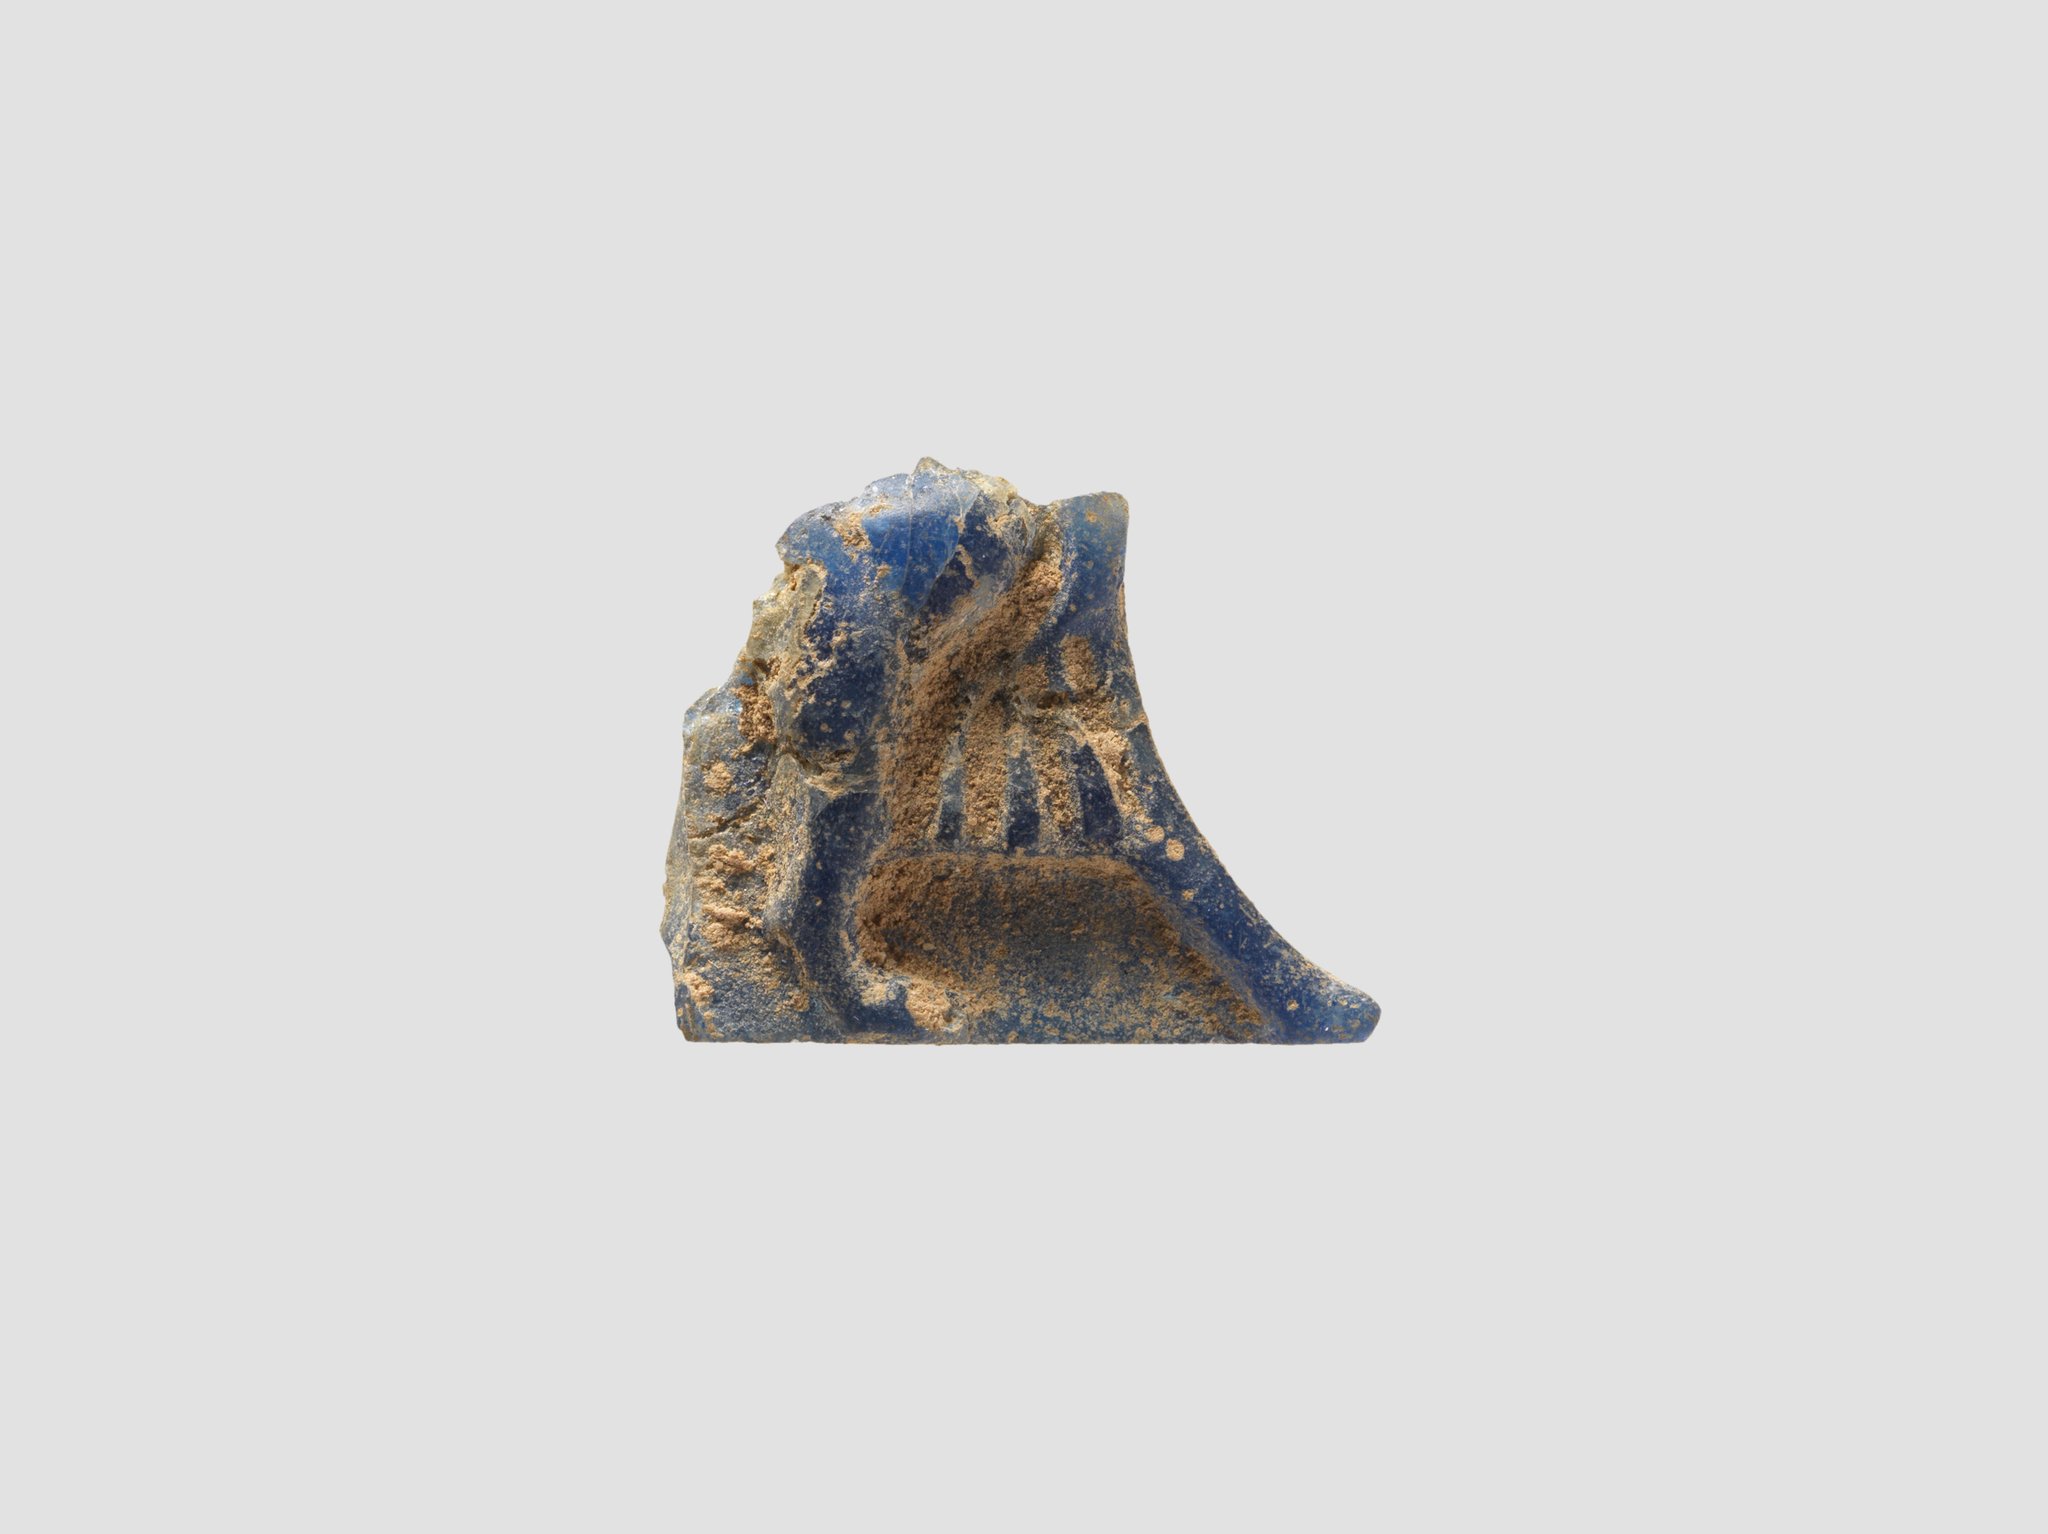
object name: inlay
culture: assyrian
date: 800-601 BCE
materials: glass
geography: mesopotamia